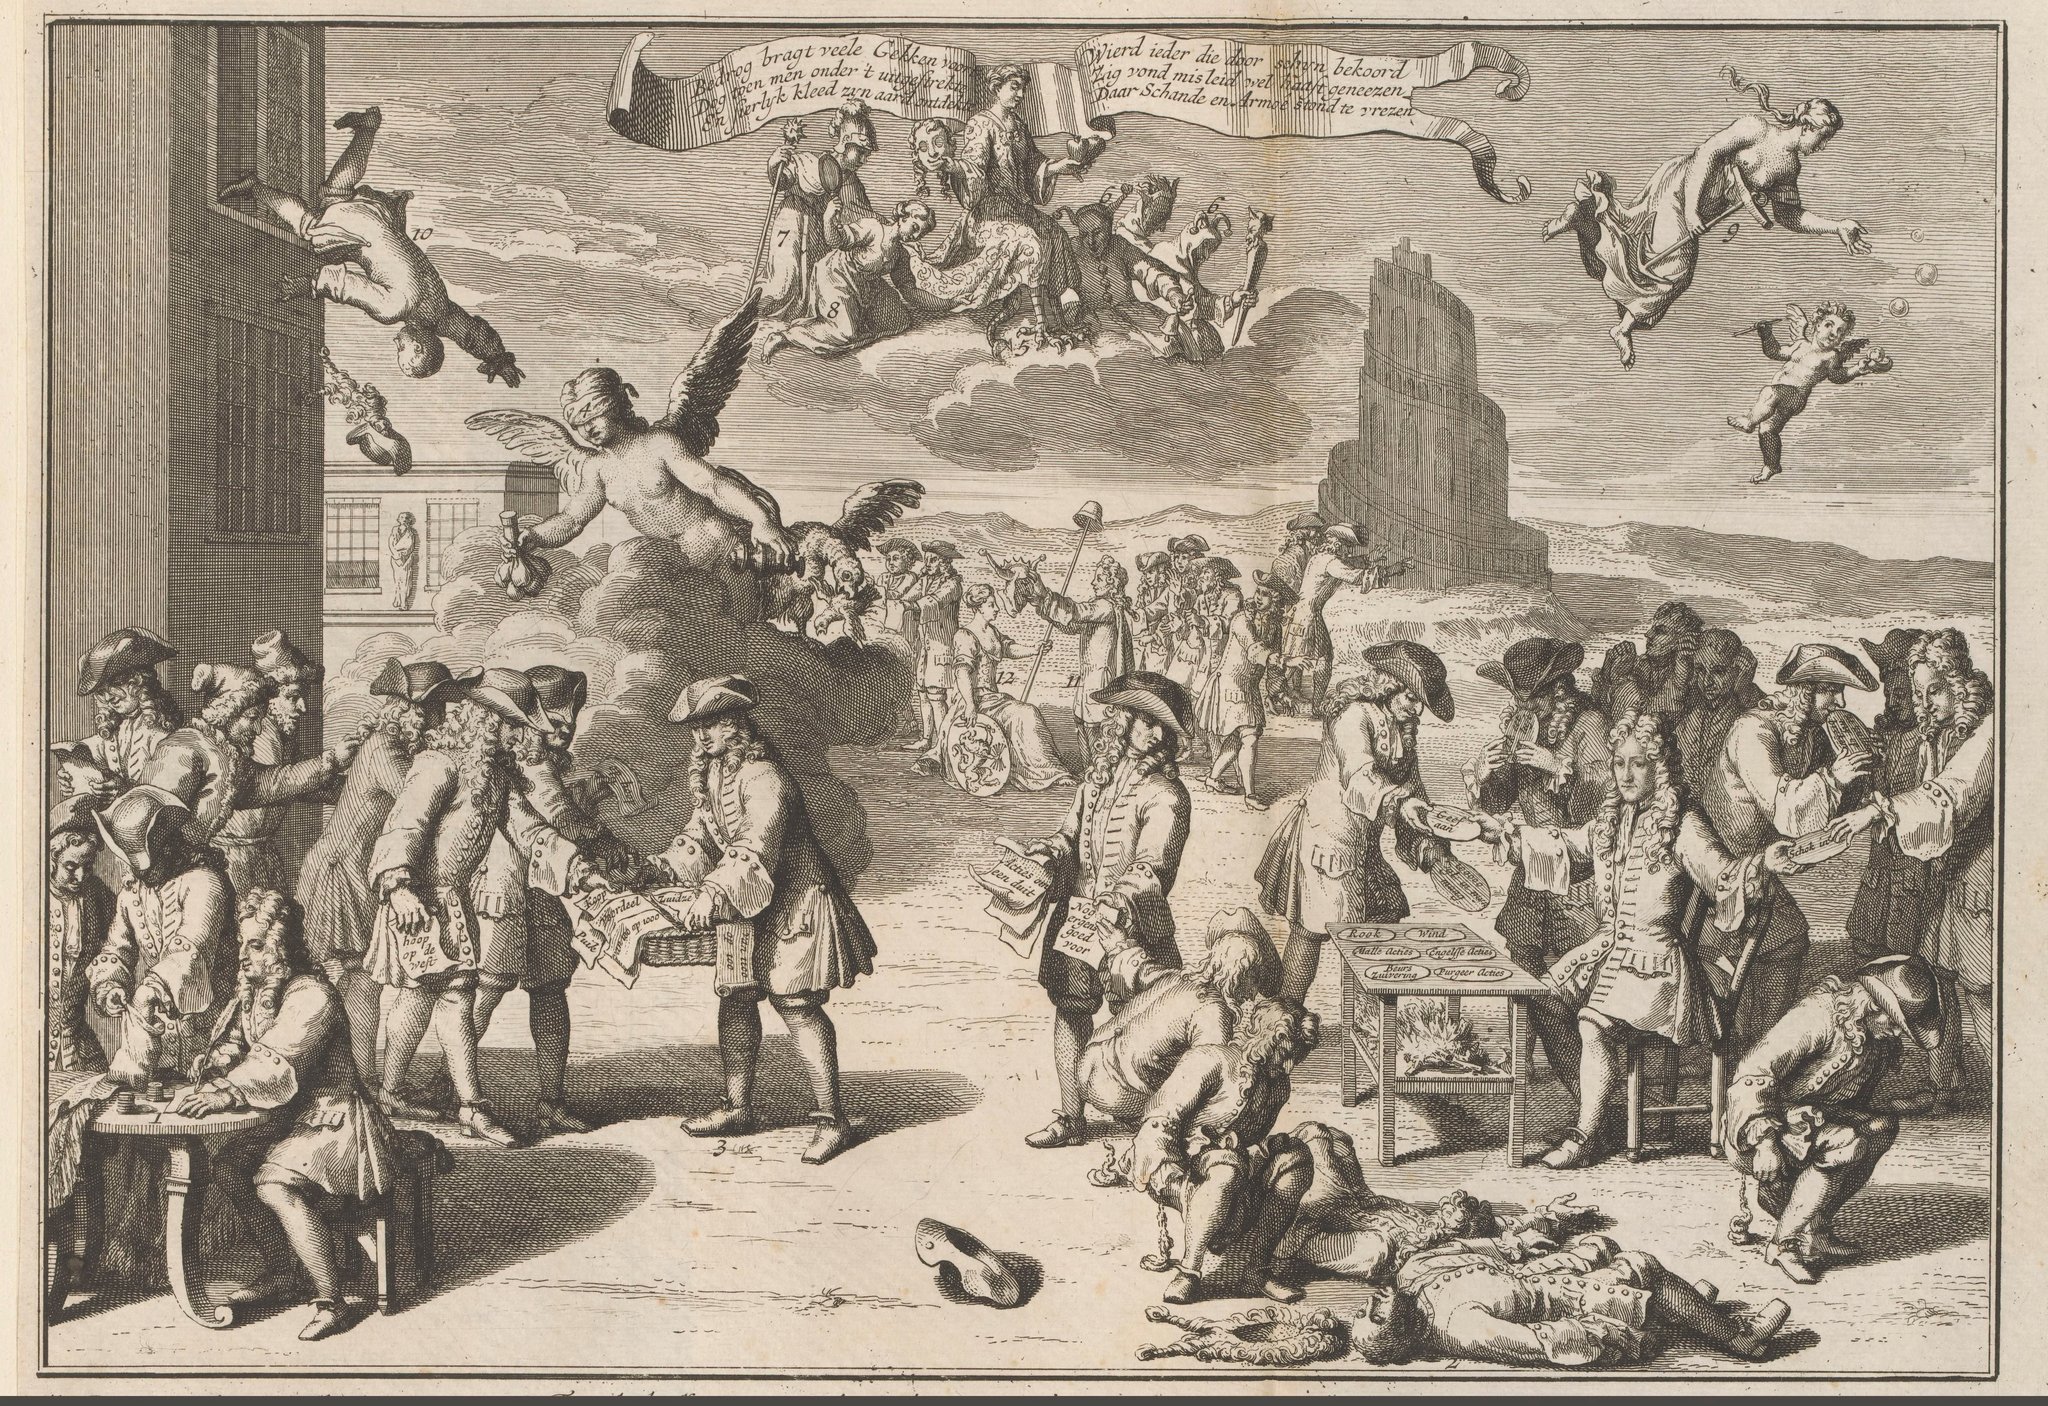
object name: print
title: De Verwarde Actionisten Torenbouw tot Babel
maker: Anonymous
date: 1720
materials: paper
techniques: etching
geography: northern netherlands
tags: the tower of babel, defecation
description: Spotprent op de Actionisten en de toren van Babel. John Law zit links aandelen uit de schrijven terwijl windhandelaren zich te goed doen aan door de Engelsen gebakken kaakjes. De handelaren raken door deze koeken aan de diarree, de waardeloze aandelen gebruiken ze om hun achterste mee af te vegen. In de voorstelling vele ander details met Fortuna, de Nederlandse Maagd, de Hoop etc. In het onderschrift een vers in 4 kolommen waarin de cijfers uit de voorstelling worden verklaard. Prent in de gebonden eerste uitgave (304 B 10) van Het Groote Tafereel der Dwaasheid met spotprenten op de Windhandel of Actiehandel van 1720.